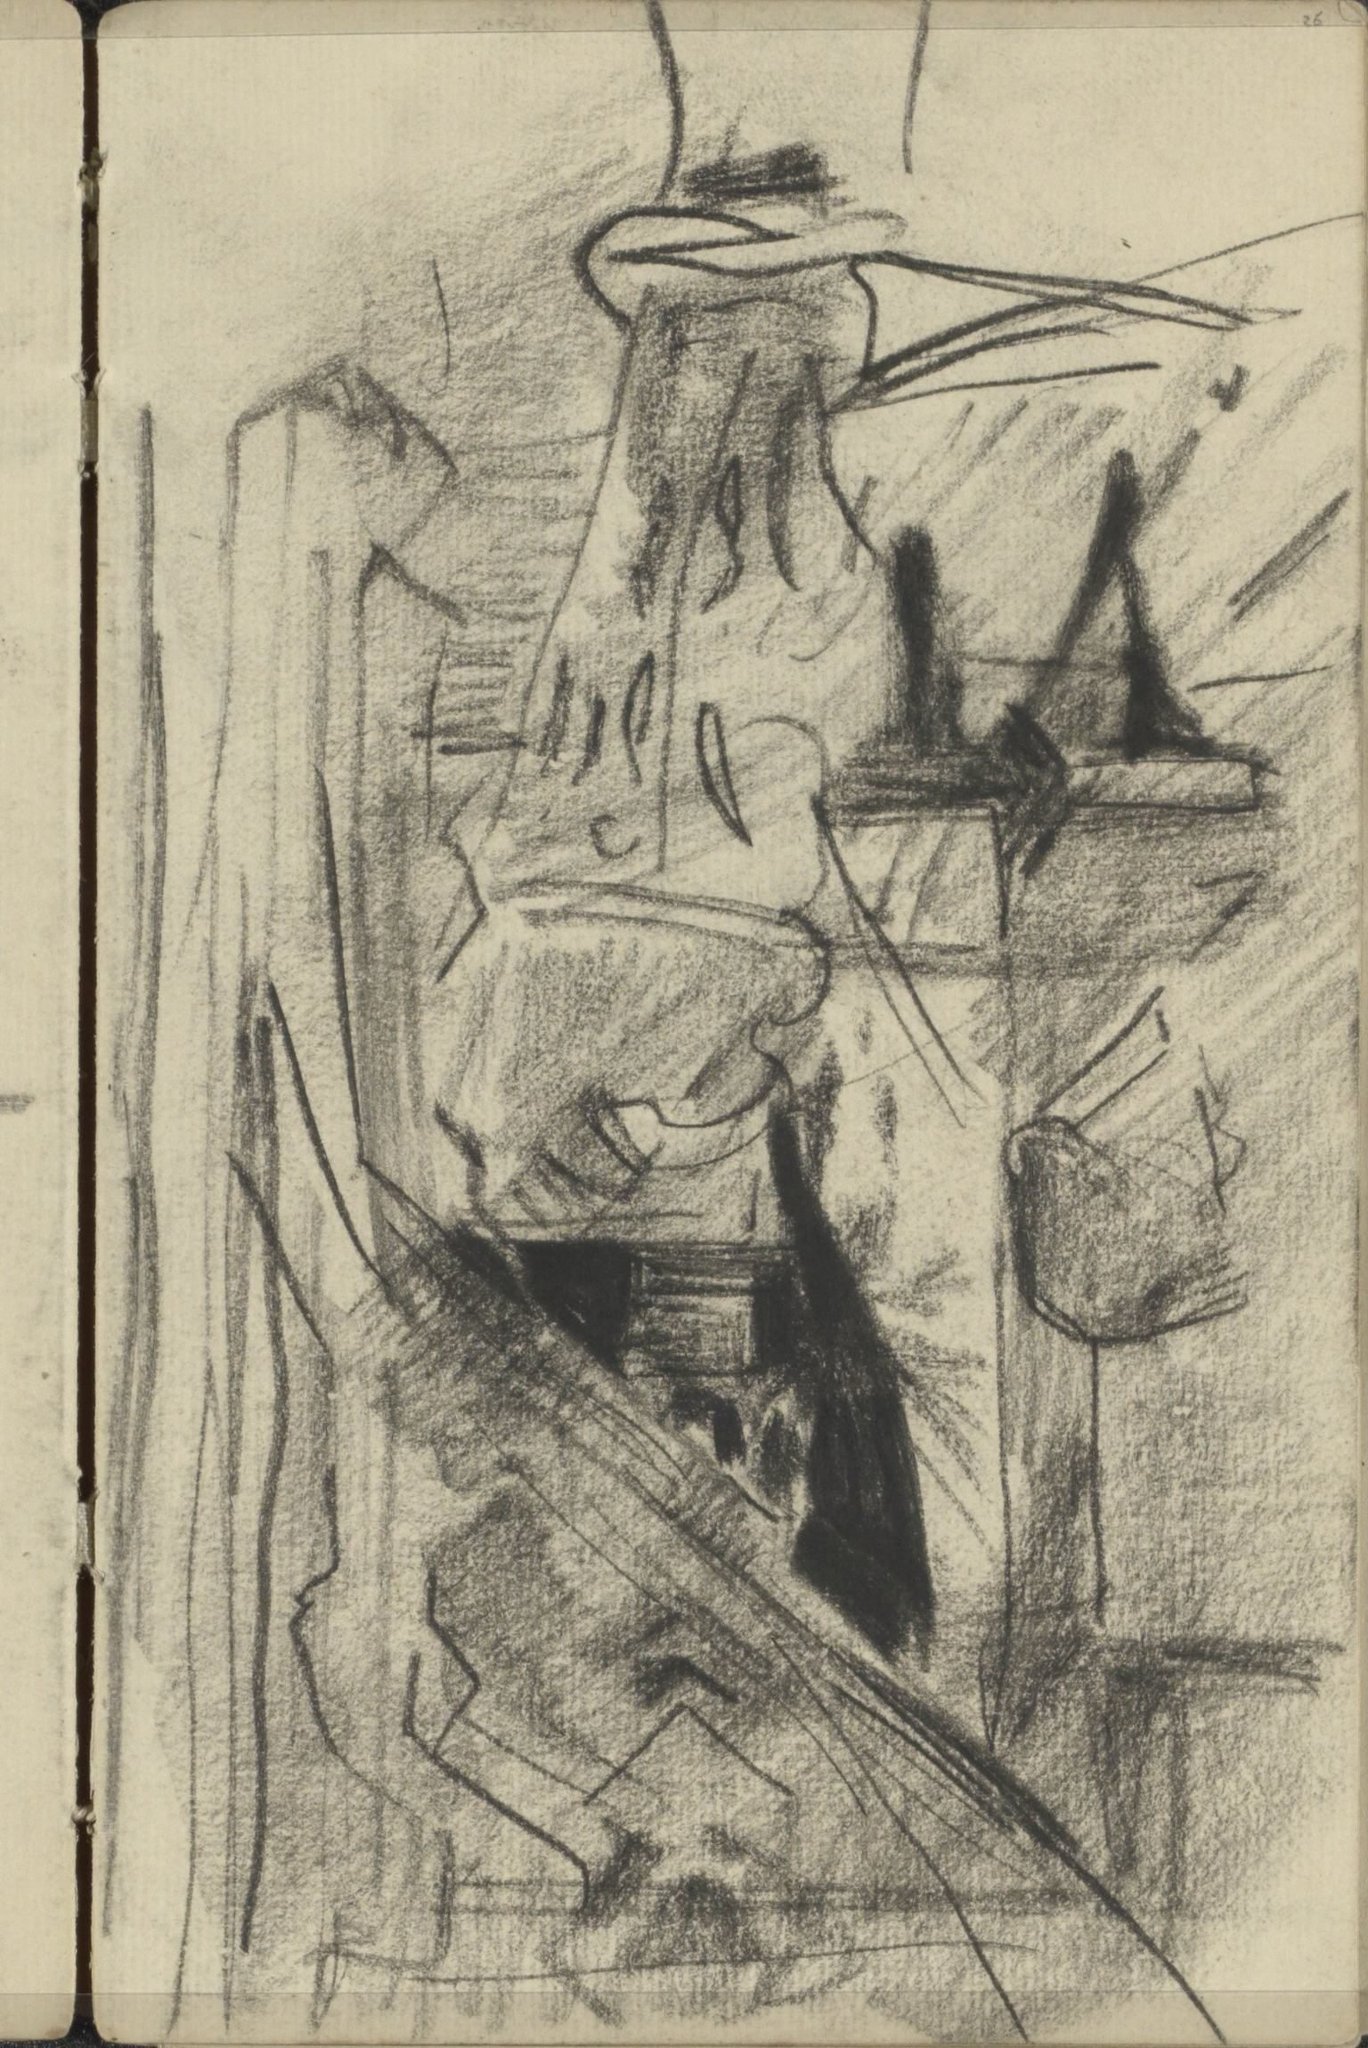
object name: sketchbook leaf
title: Man in een interieur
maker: george hendrik breitner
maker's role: draughtsman, painter, print maker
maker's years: 1857-1923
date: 1882-1884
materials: chalk, paper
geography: the hague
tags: adult man, interior of the house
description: Pagina 26 uit een schetsboek met 24 bladen.